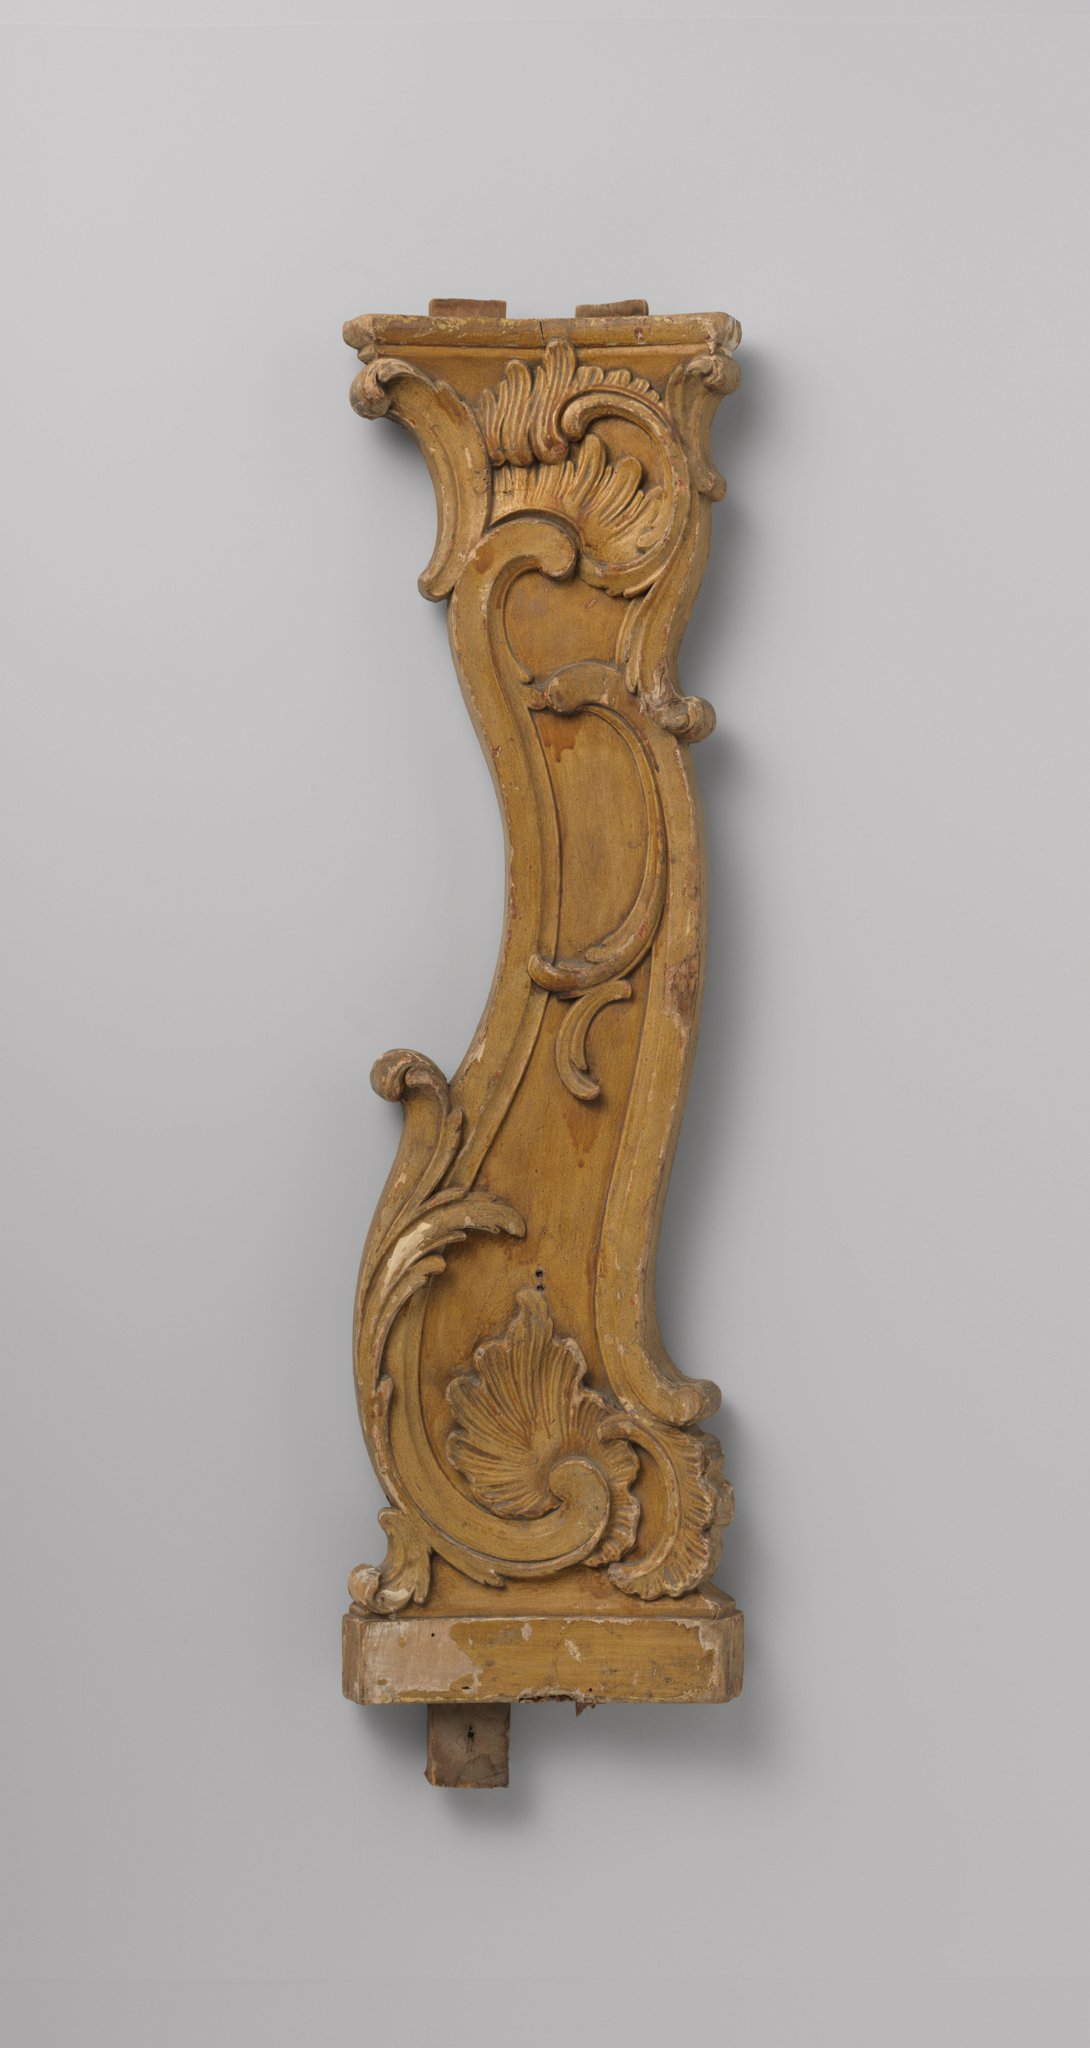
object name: railing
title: Baluster met gestoken C- en S-voluten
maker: Anonymous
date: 1740-1760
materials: wood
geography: northern netherlands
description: S-vormige baluster met gestoken C- en S-voluten met rocaille-schelpen.